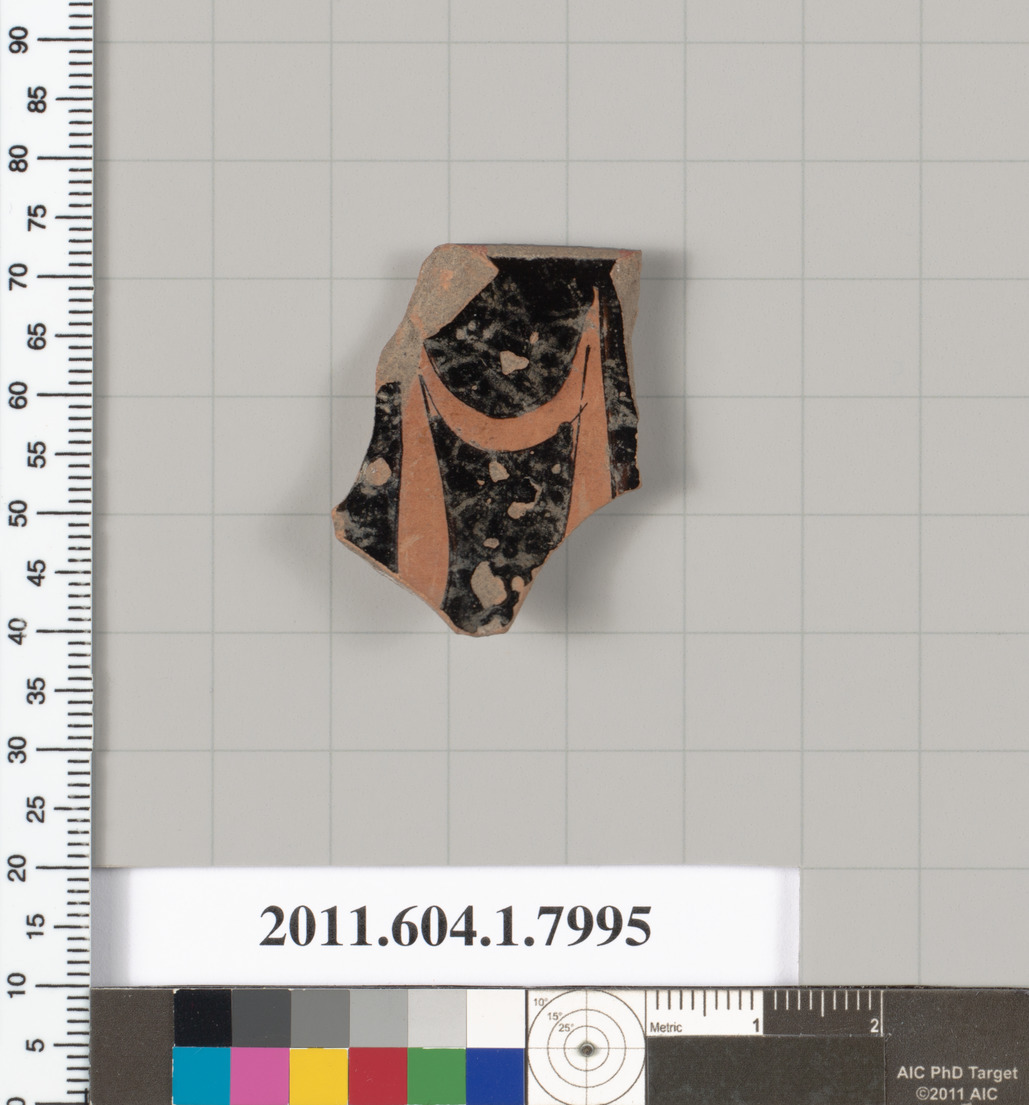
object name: kylix fragment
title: Terracotta rim fragment of a kylix (drinking cup)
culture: greek, attic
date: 460-450 BCE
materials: terracotta